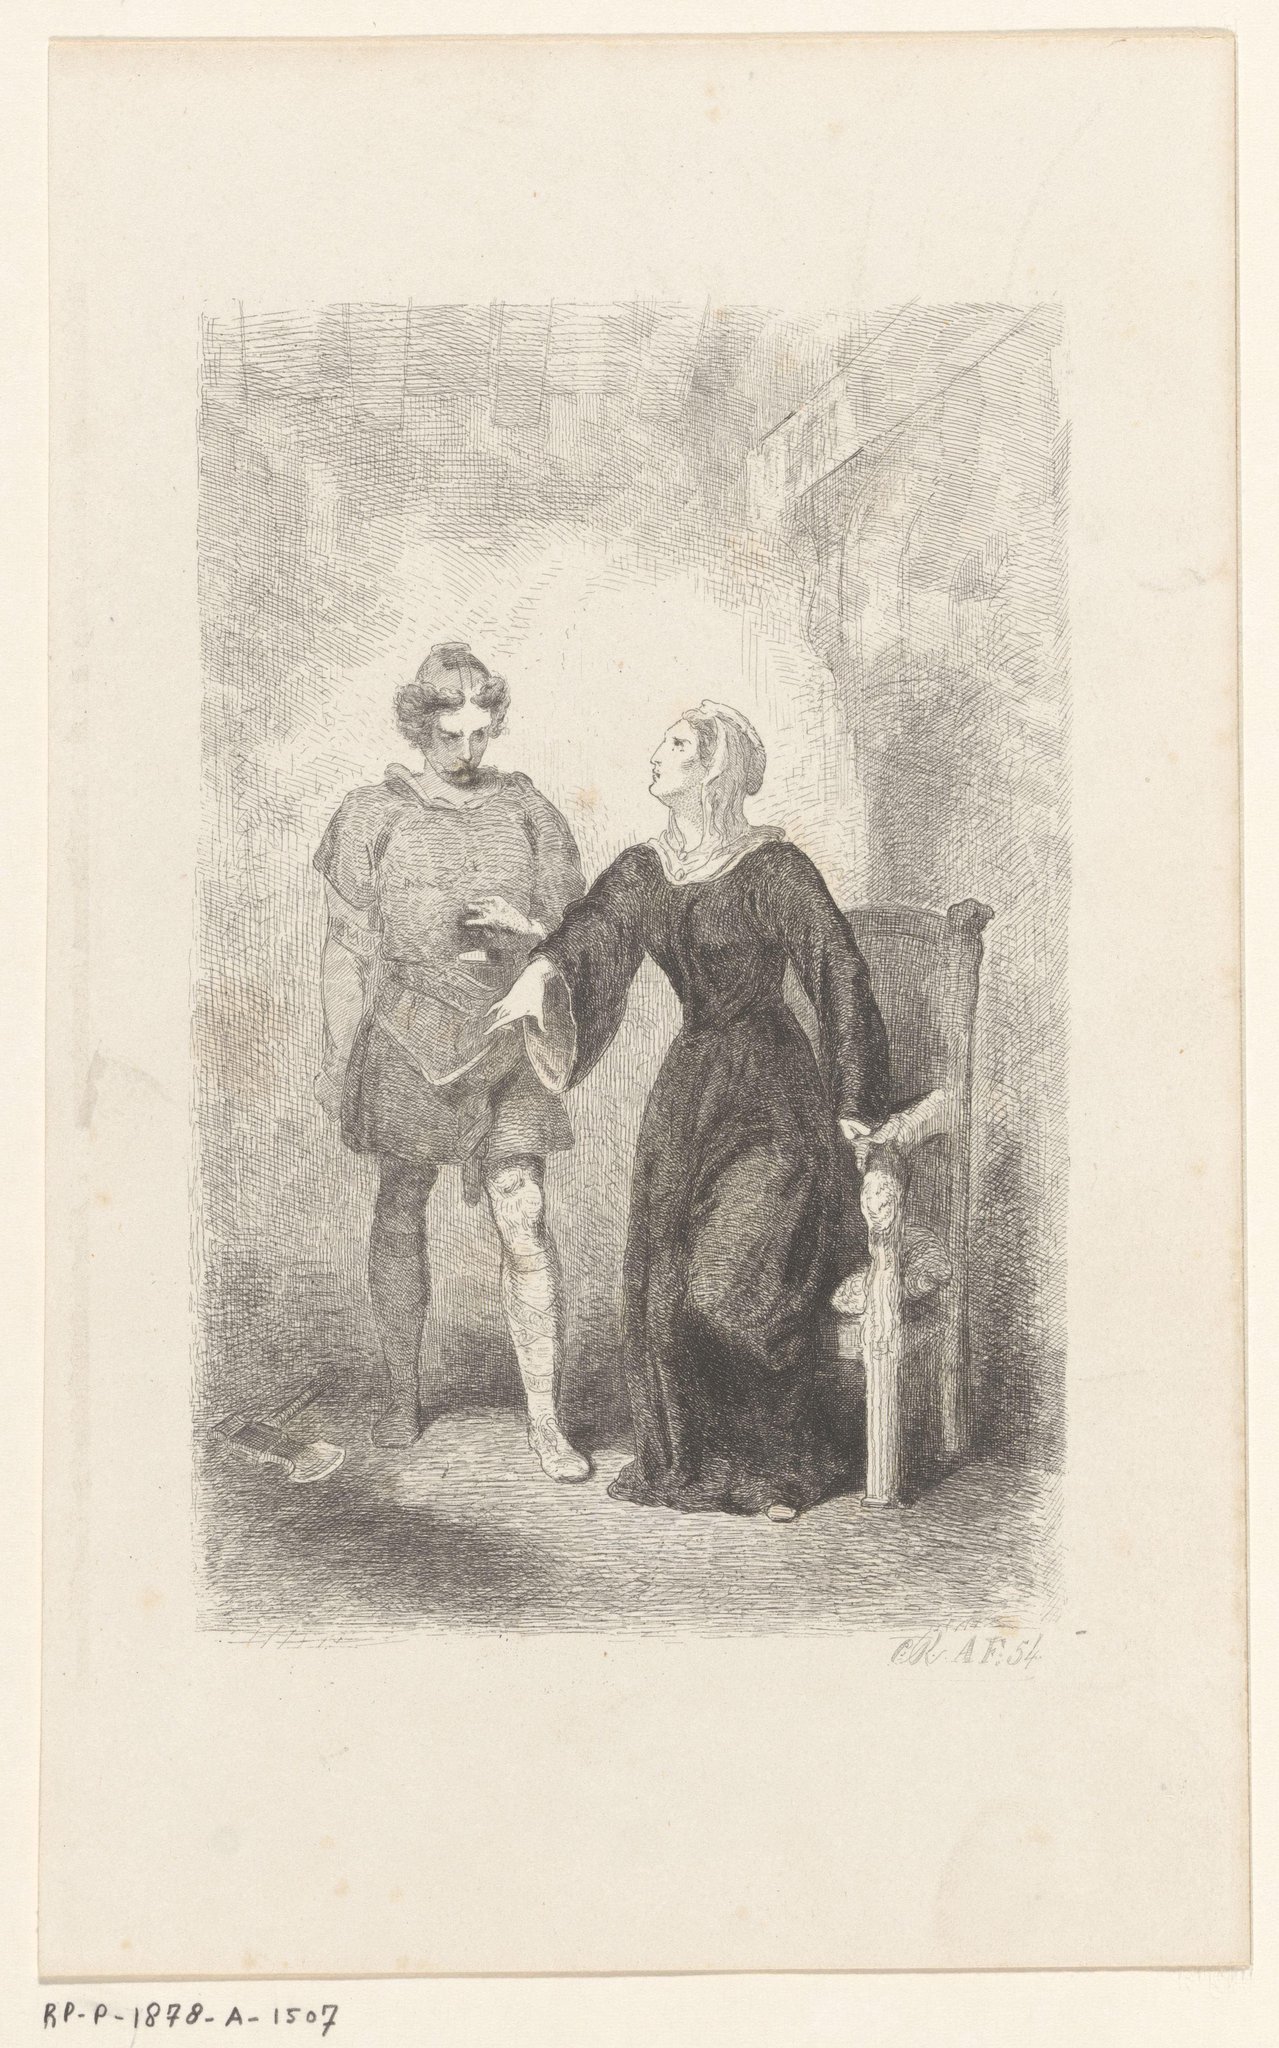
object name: print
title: Wilfried bij zijn moeder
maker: charles rochussen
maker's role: draughtsman, painter, print maker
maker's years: 1814-1894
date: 1854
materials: paper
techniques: steel etching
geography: amsterdam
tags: mother with son(s) and daughter(s) (mother-love)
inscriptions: collector's mark: Lugt 2228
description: Wilfried komt bij zijn moeder. Illustratie van een scène uit een boek met gedichten genaamd 'Helene'.